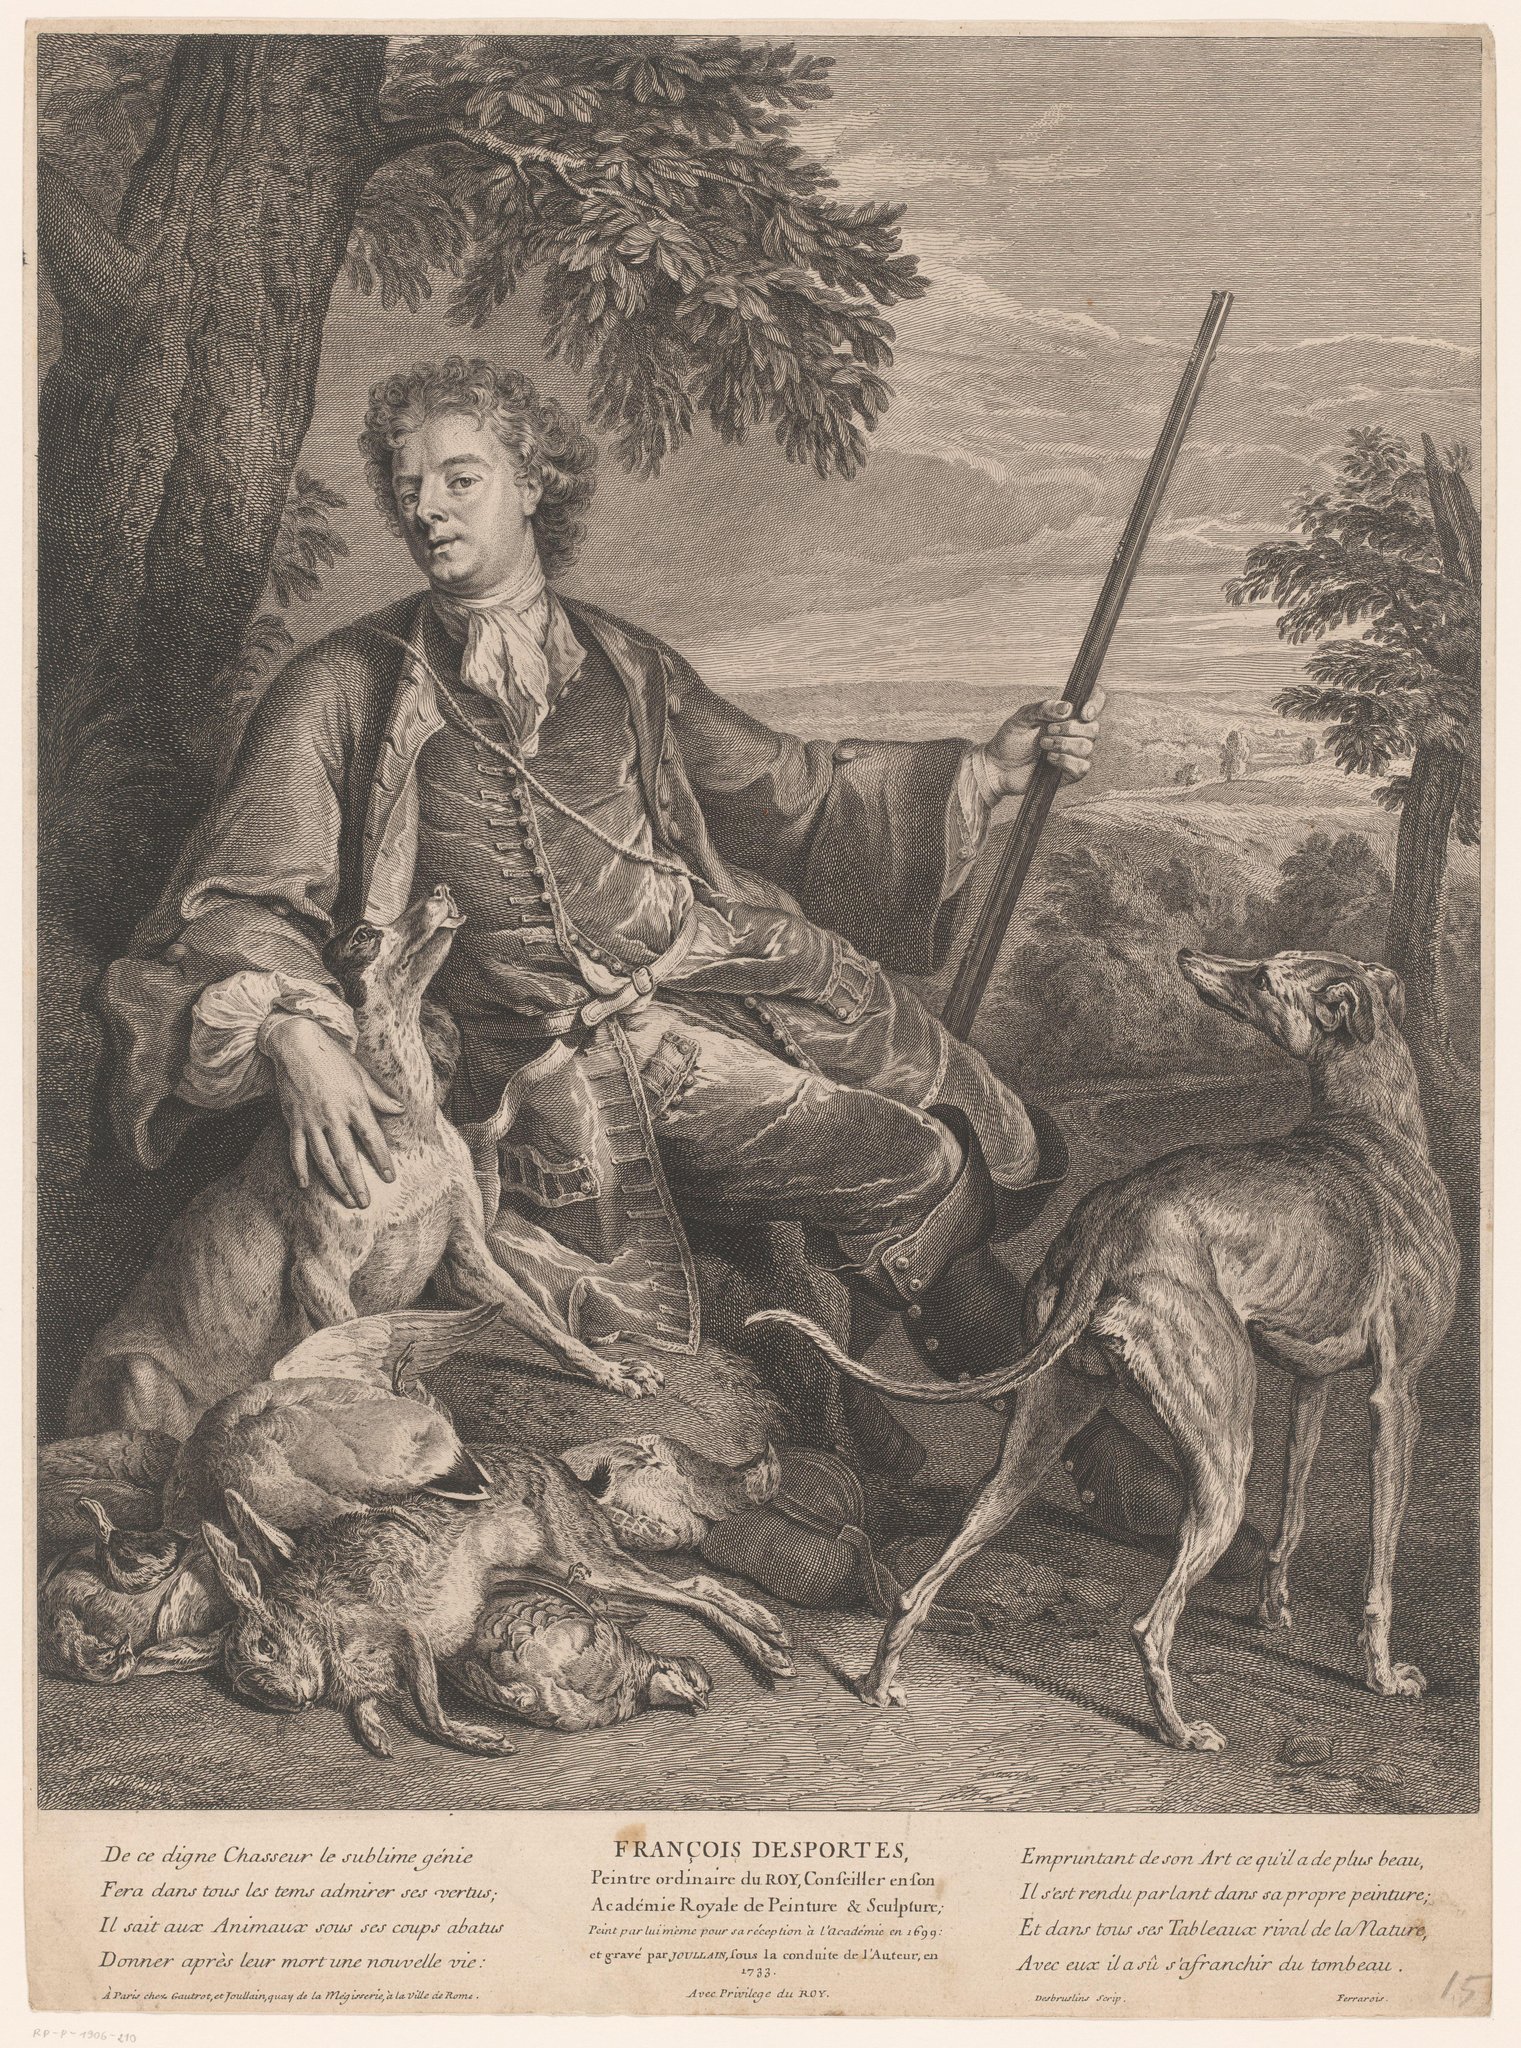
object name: print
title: Portret van Alexandre-François Desportes na de jacht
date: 1733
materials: paper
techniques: engraving, etching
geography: paris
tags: painter, françois desportes, hunting dogs, historical persons, game, hunted animals, portrait, self-portrait of painter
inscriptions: collector's mark: Lugt 2228